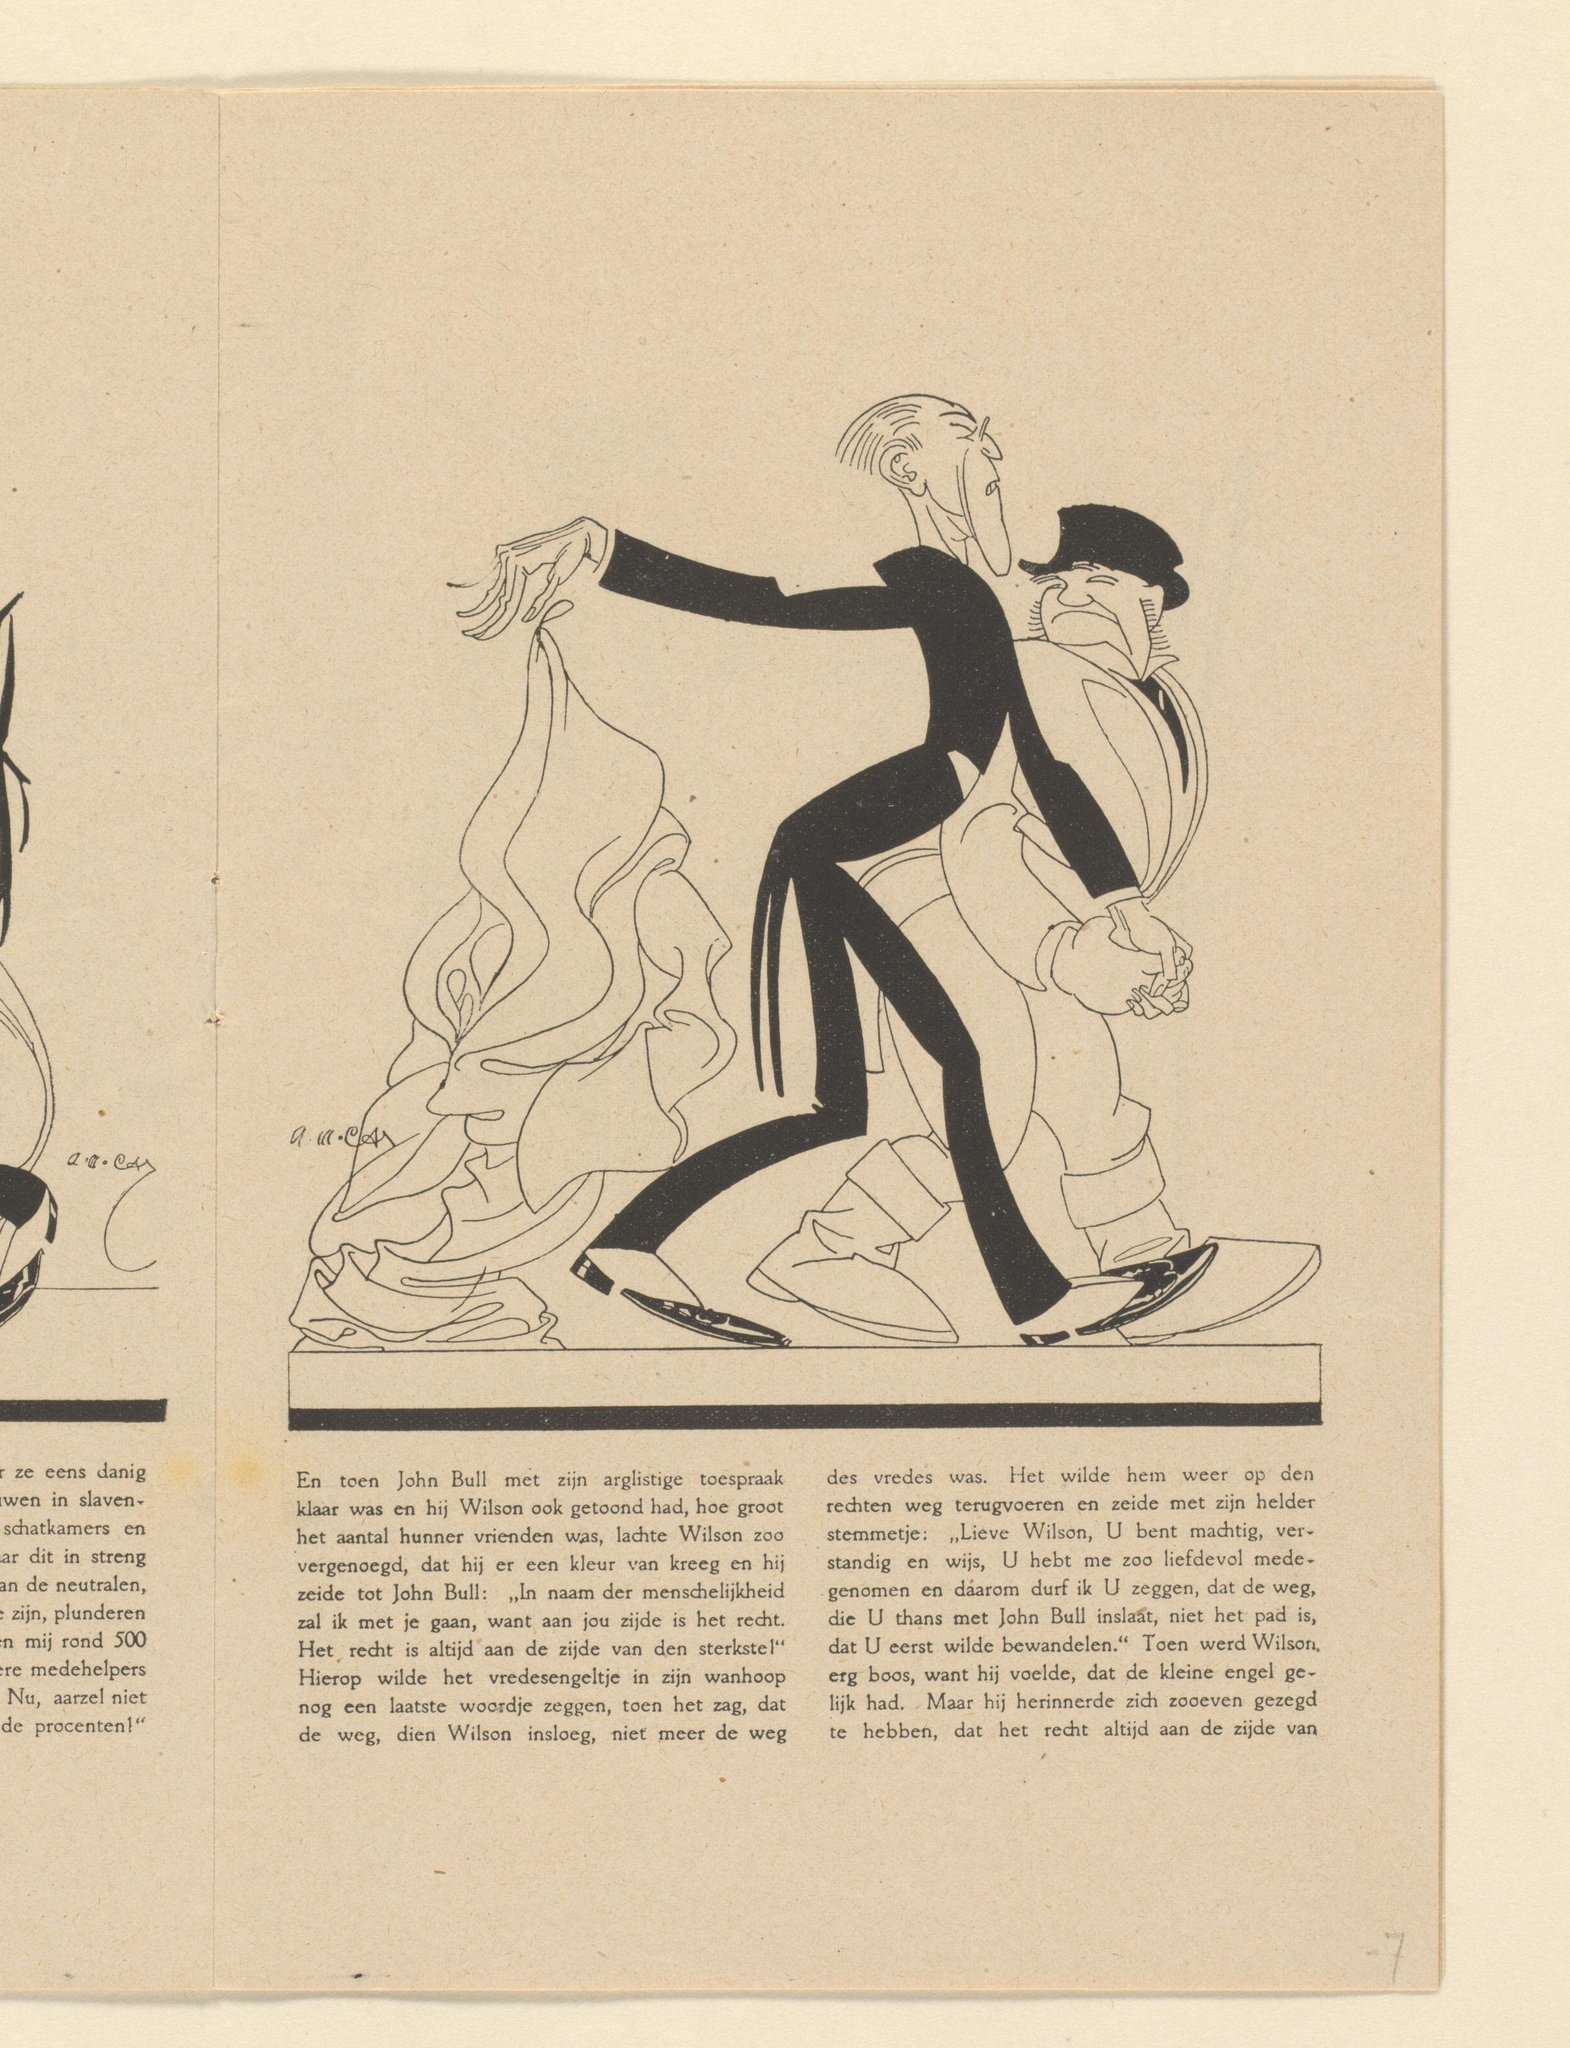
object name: photomechanical print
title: John Bull en Woodrow Wilson lopen hand in hand terwijl Wilson het vredeskleed afwerpt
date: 1917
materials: paper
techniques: printing block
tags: president ~ head of republic, political caricatures and satires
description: Prent uit: Cay, A.M. Wilson de menschenvriend; een modern sprookje. S.l.: s.n., ca. 1917.